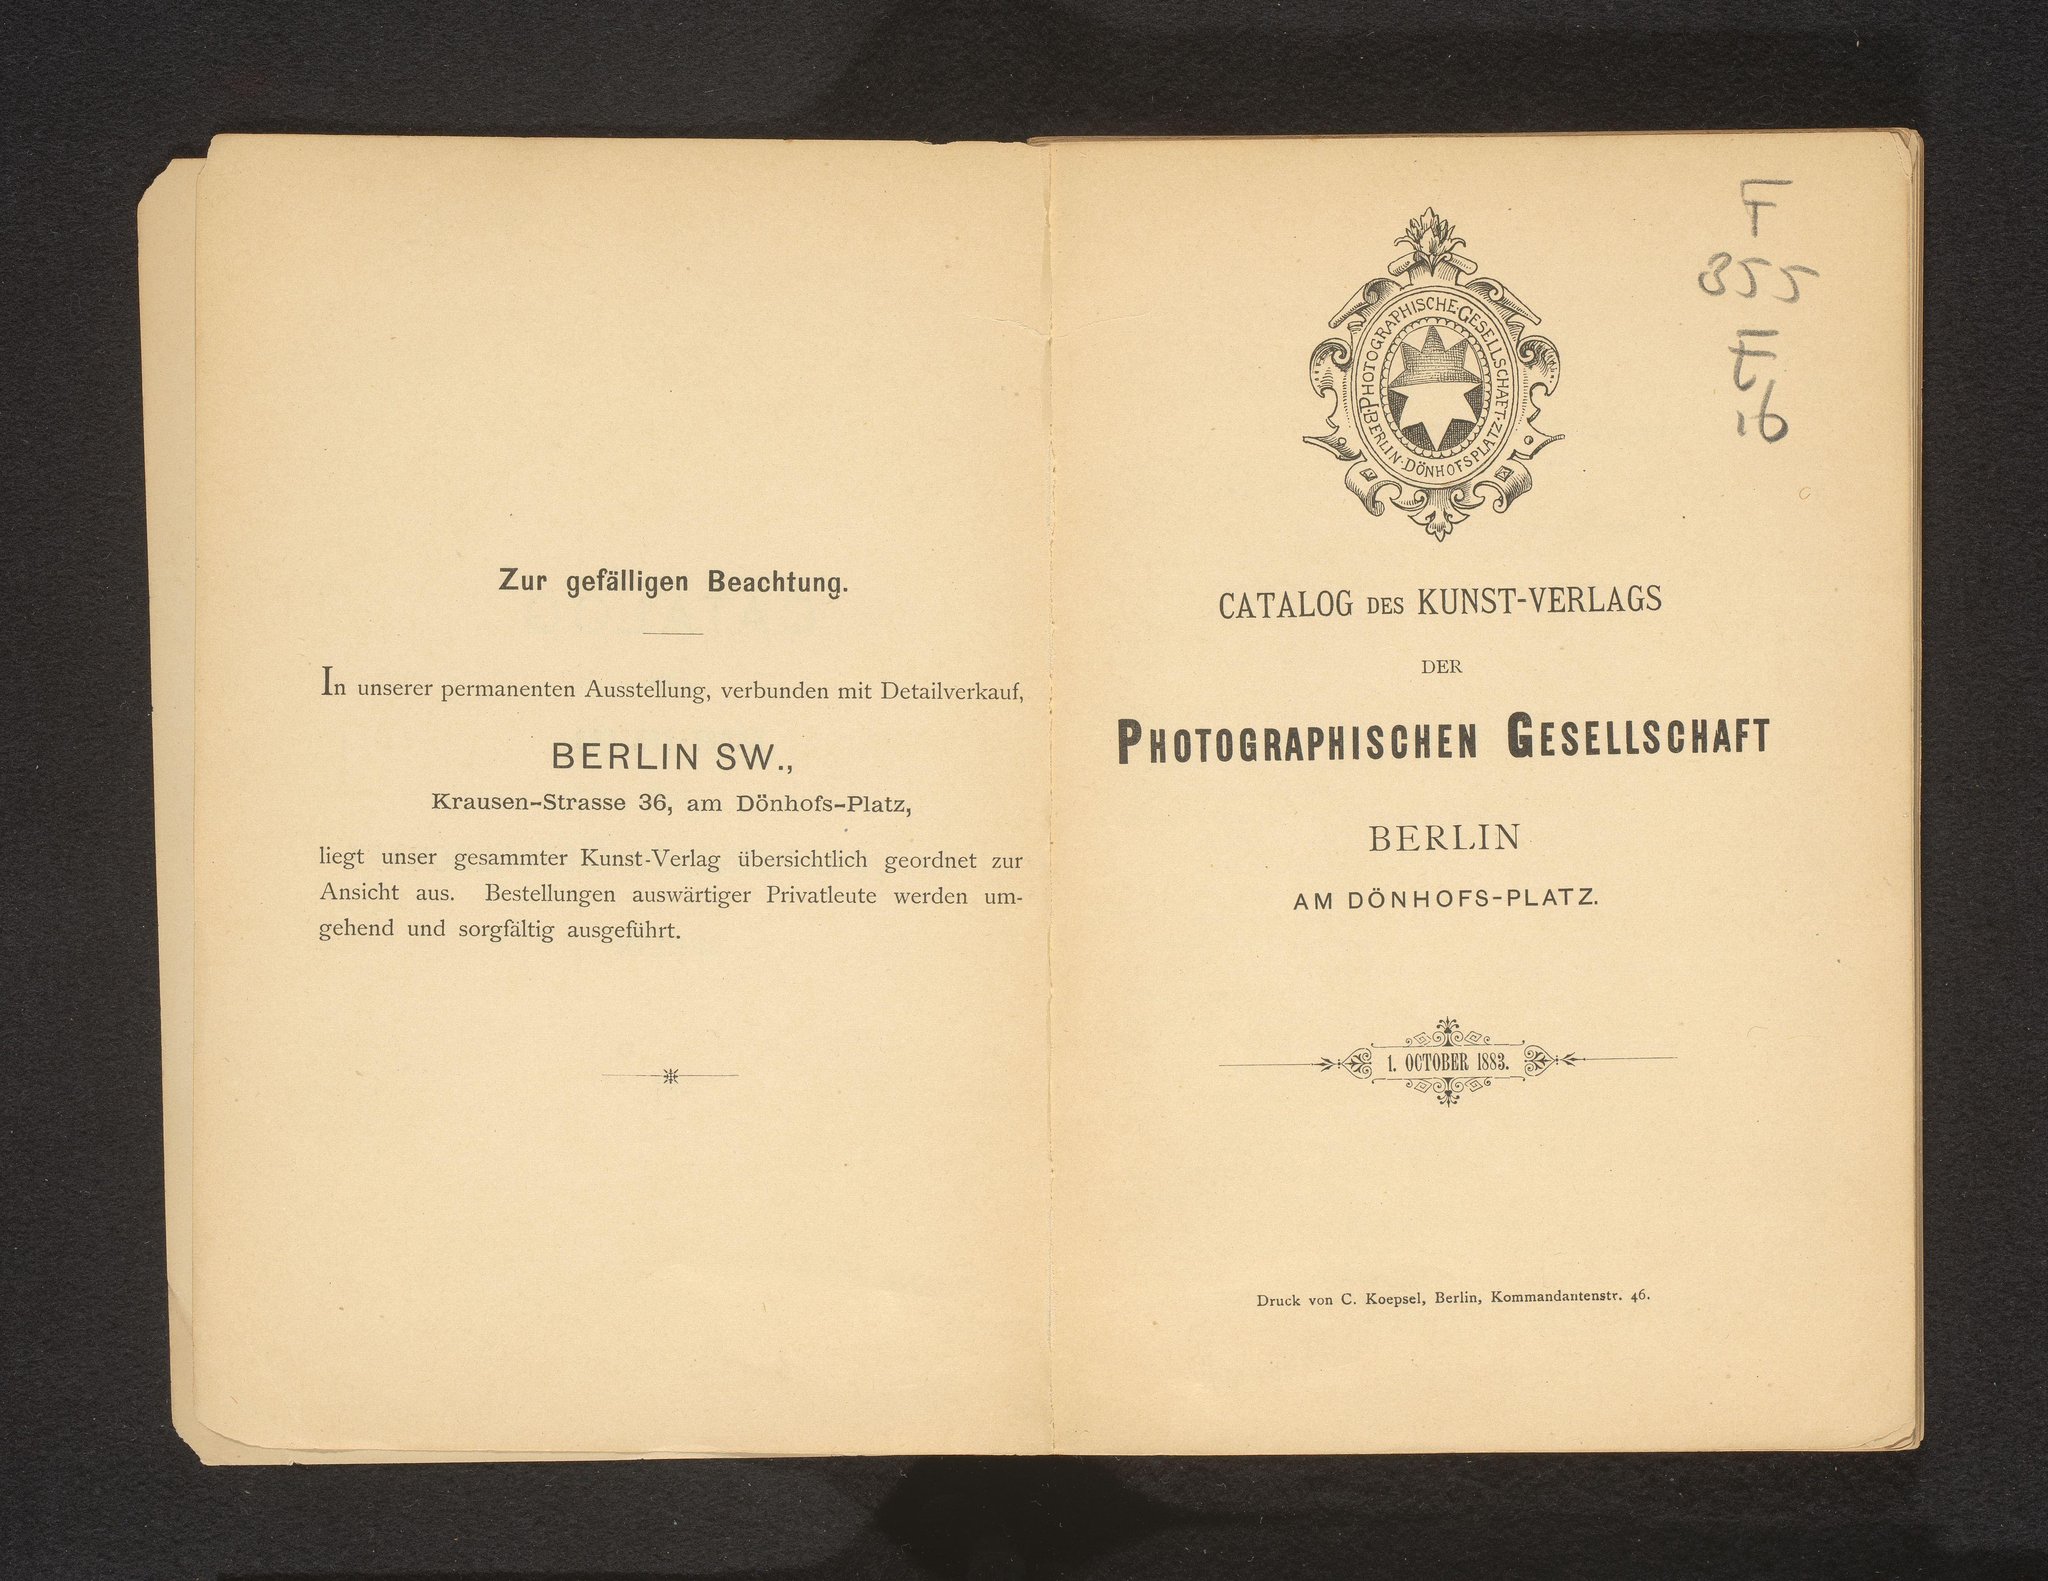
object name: book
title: Catalog des Kunstverlags der Photographischen Gesellschaft Berlin 1. October 1883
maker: c. koepsel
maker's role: printer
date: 1883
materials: paper, photographic support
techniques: albumen print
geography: berlin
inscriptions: name: ‘Henri Hymans, Bruxelles’